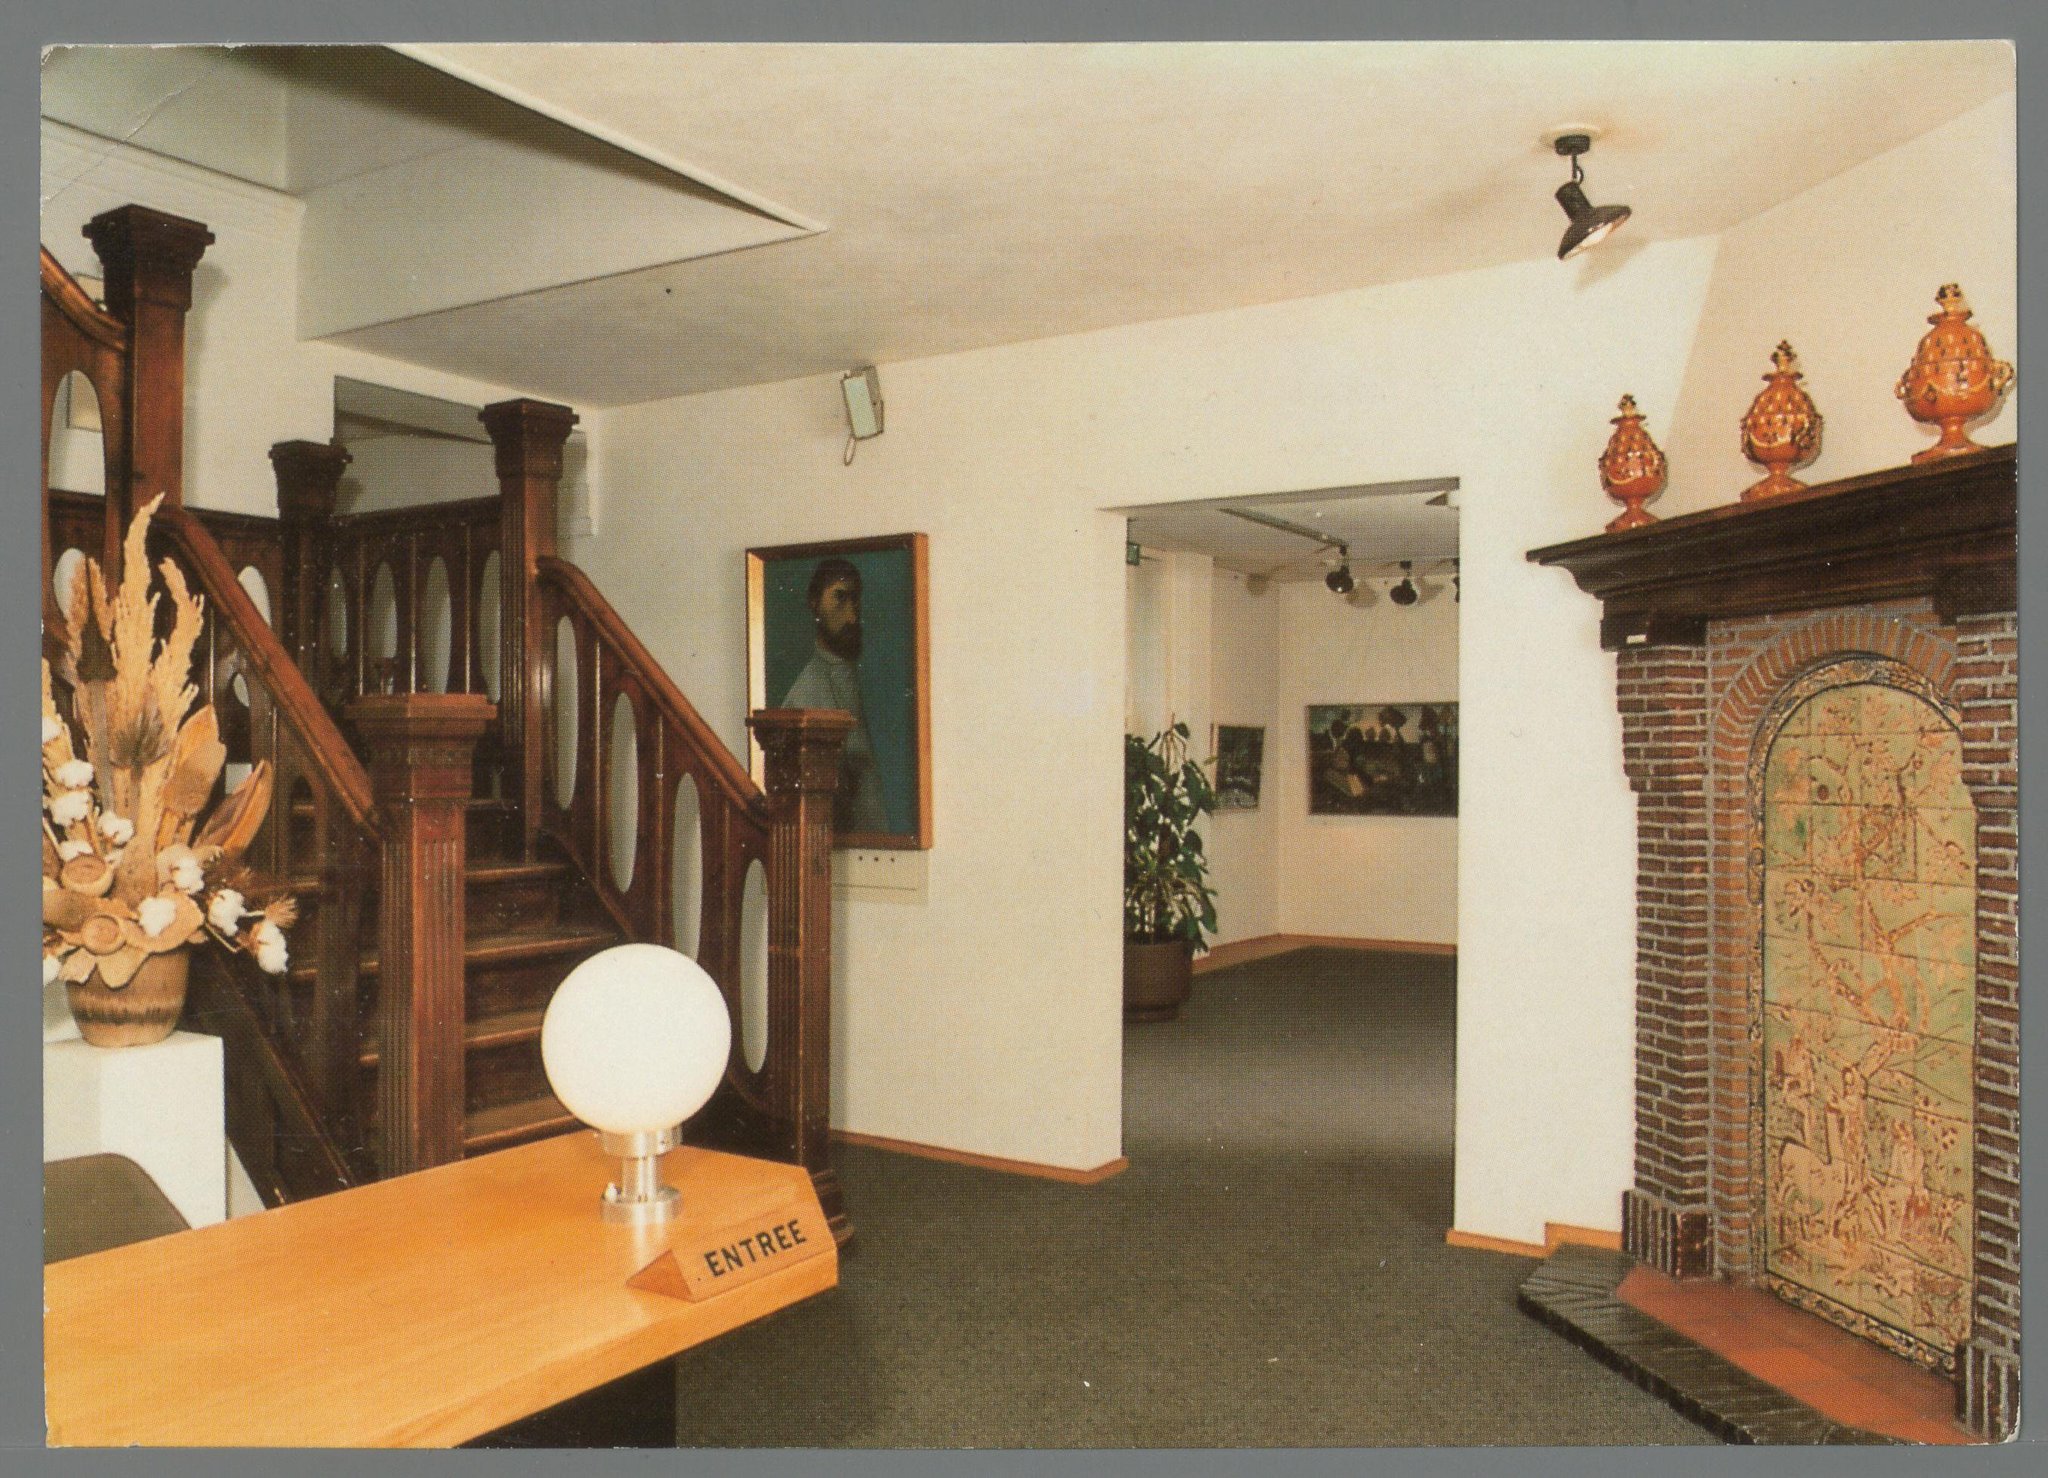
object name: photomechanical print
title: Gemeentemuseum "de Wieger". Deurne (N.B.)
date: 1903-1981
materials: cardboard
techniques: offset printed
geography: arnhem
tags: permanent exhibition, museum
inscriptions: poststempel, verso, gestempeld